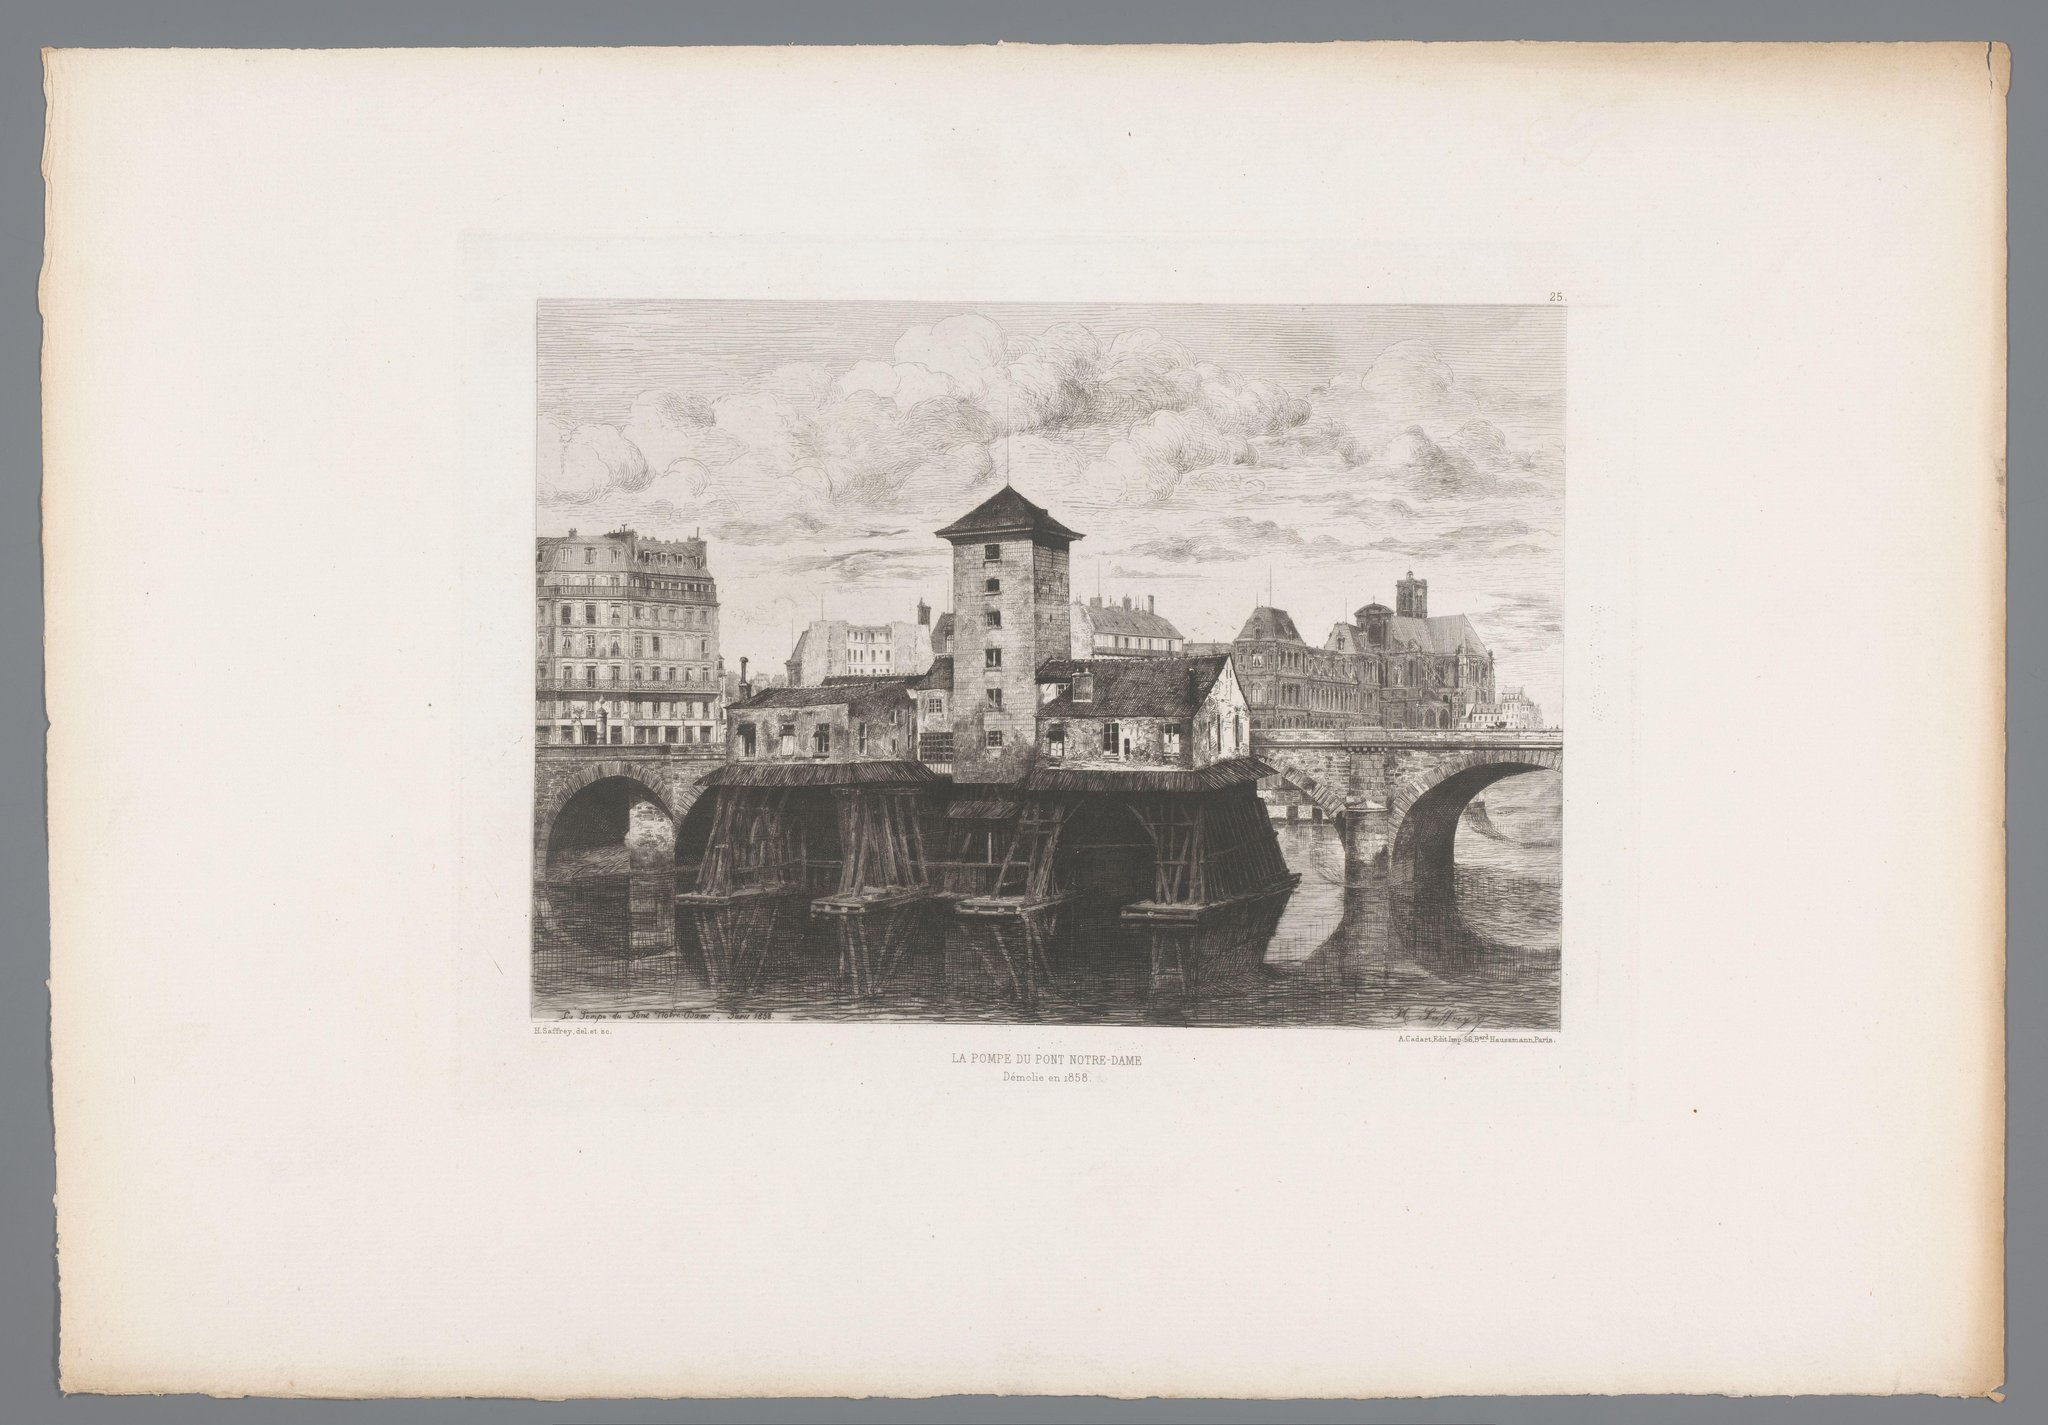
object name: print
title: La pompe du Pont Notre-Dame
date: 1875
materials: paper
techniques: drypoint, etching, intaglio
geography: paris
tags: bridge in city across river, canal, etc.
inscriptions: watermark, collector's mark: Lugt 2228, collector's mark: Lugt 2760, collector's mark: ‘AFE v S’